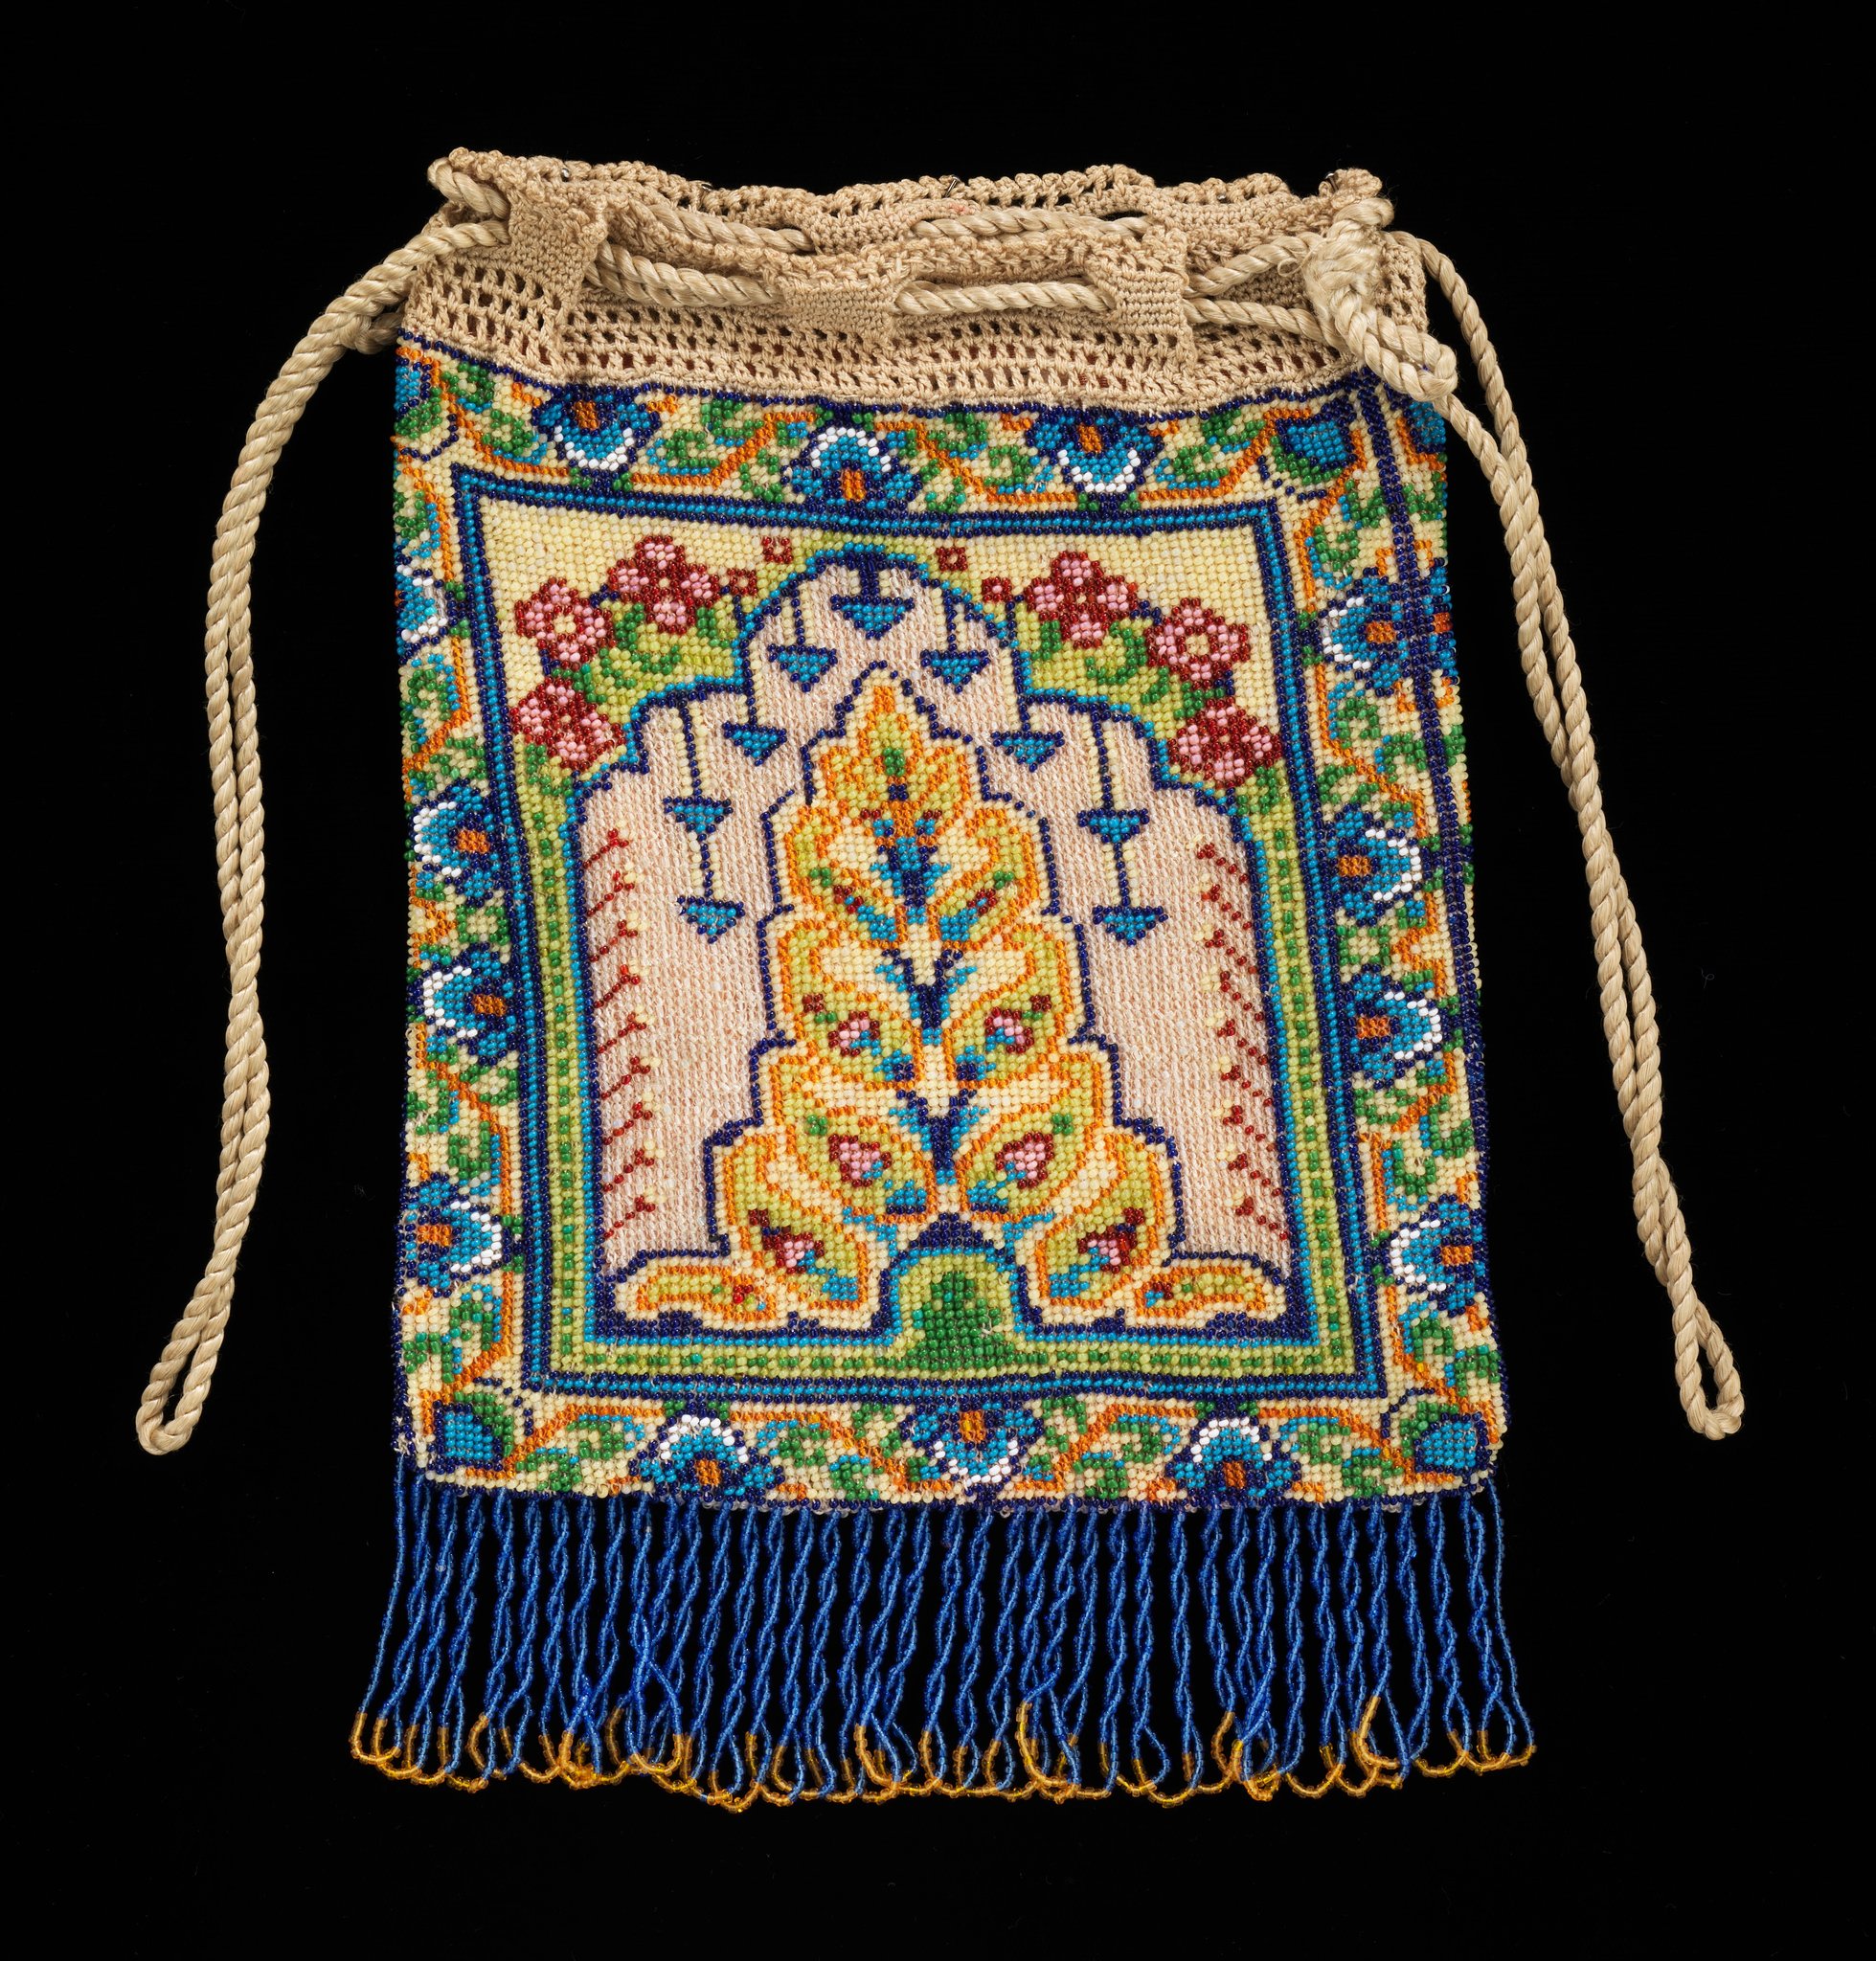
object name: pouch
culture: french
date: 1830-1860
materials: glass, linen, silk